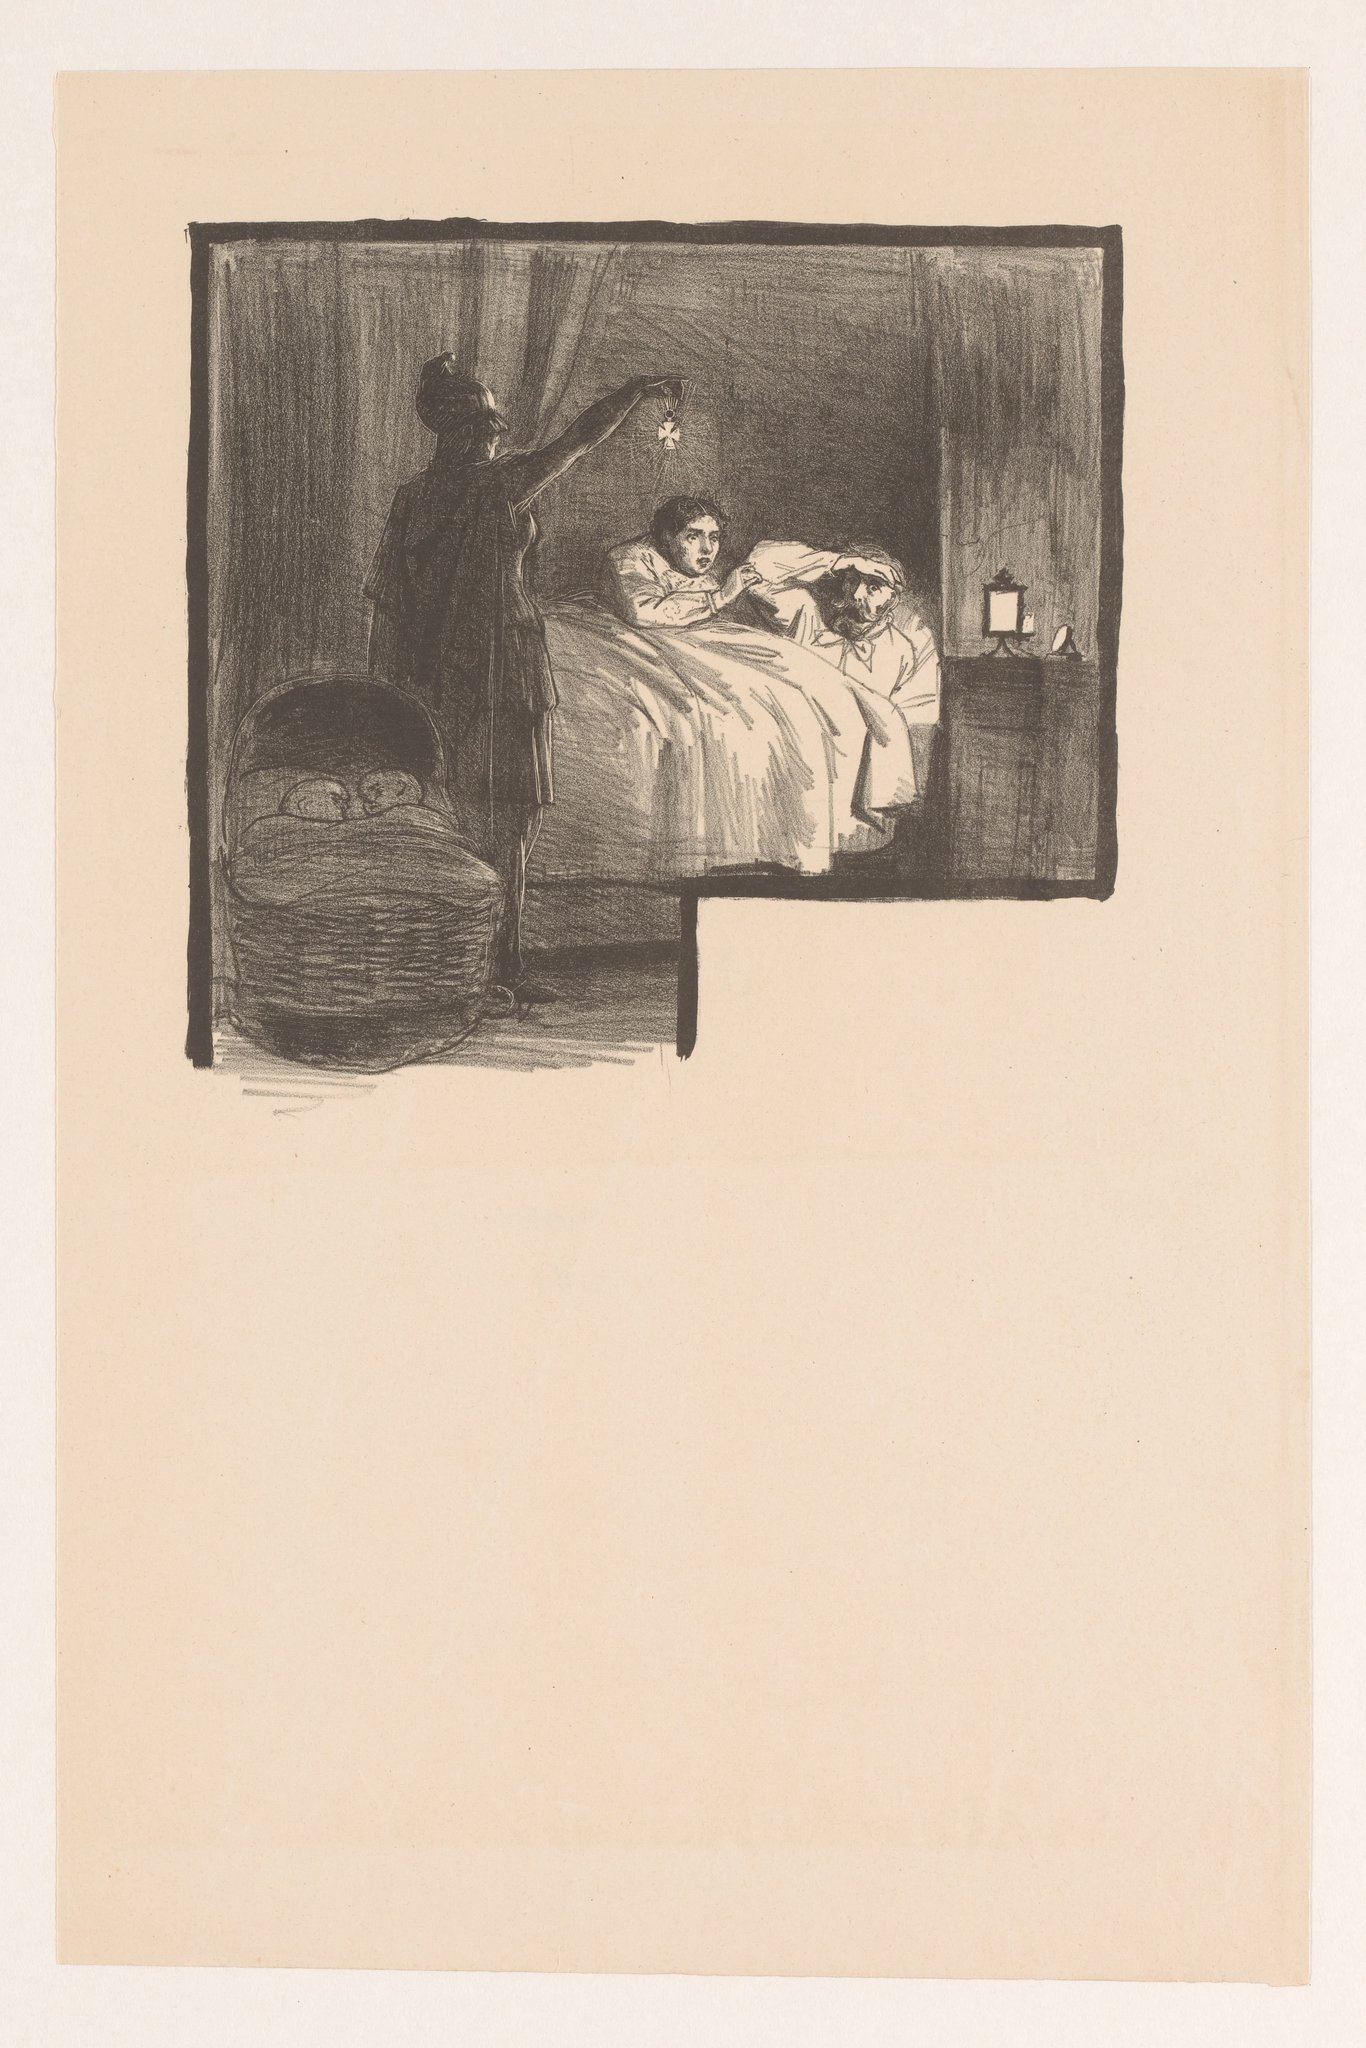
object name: print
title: Man en vrouw worden gewekt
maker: willem steelink (ii)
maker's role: draughtsman, print maker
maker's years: 1856-1928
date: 1866-1928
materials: paper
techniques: lithograph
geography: netherlands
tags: (story of) minerva (pallas, athena), cradle, crib, waking up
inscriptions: collector's mark: Lugt 2228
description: Een man en vrouw worden gewekt door een vrouw op de rug gezien, mogelijk Minerva, met een medaille in haar hand. Links liggen twee kinderen in een wieg.